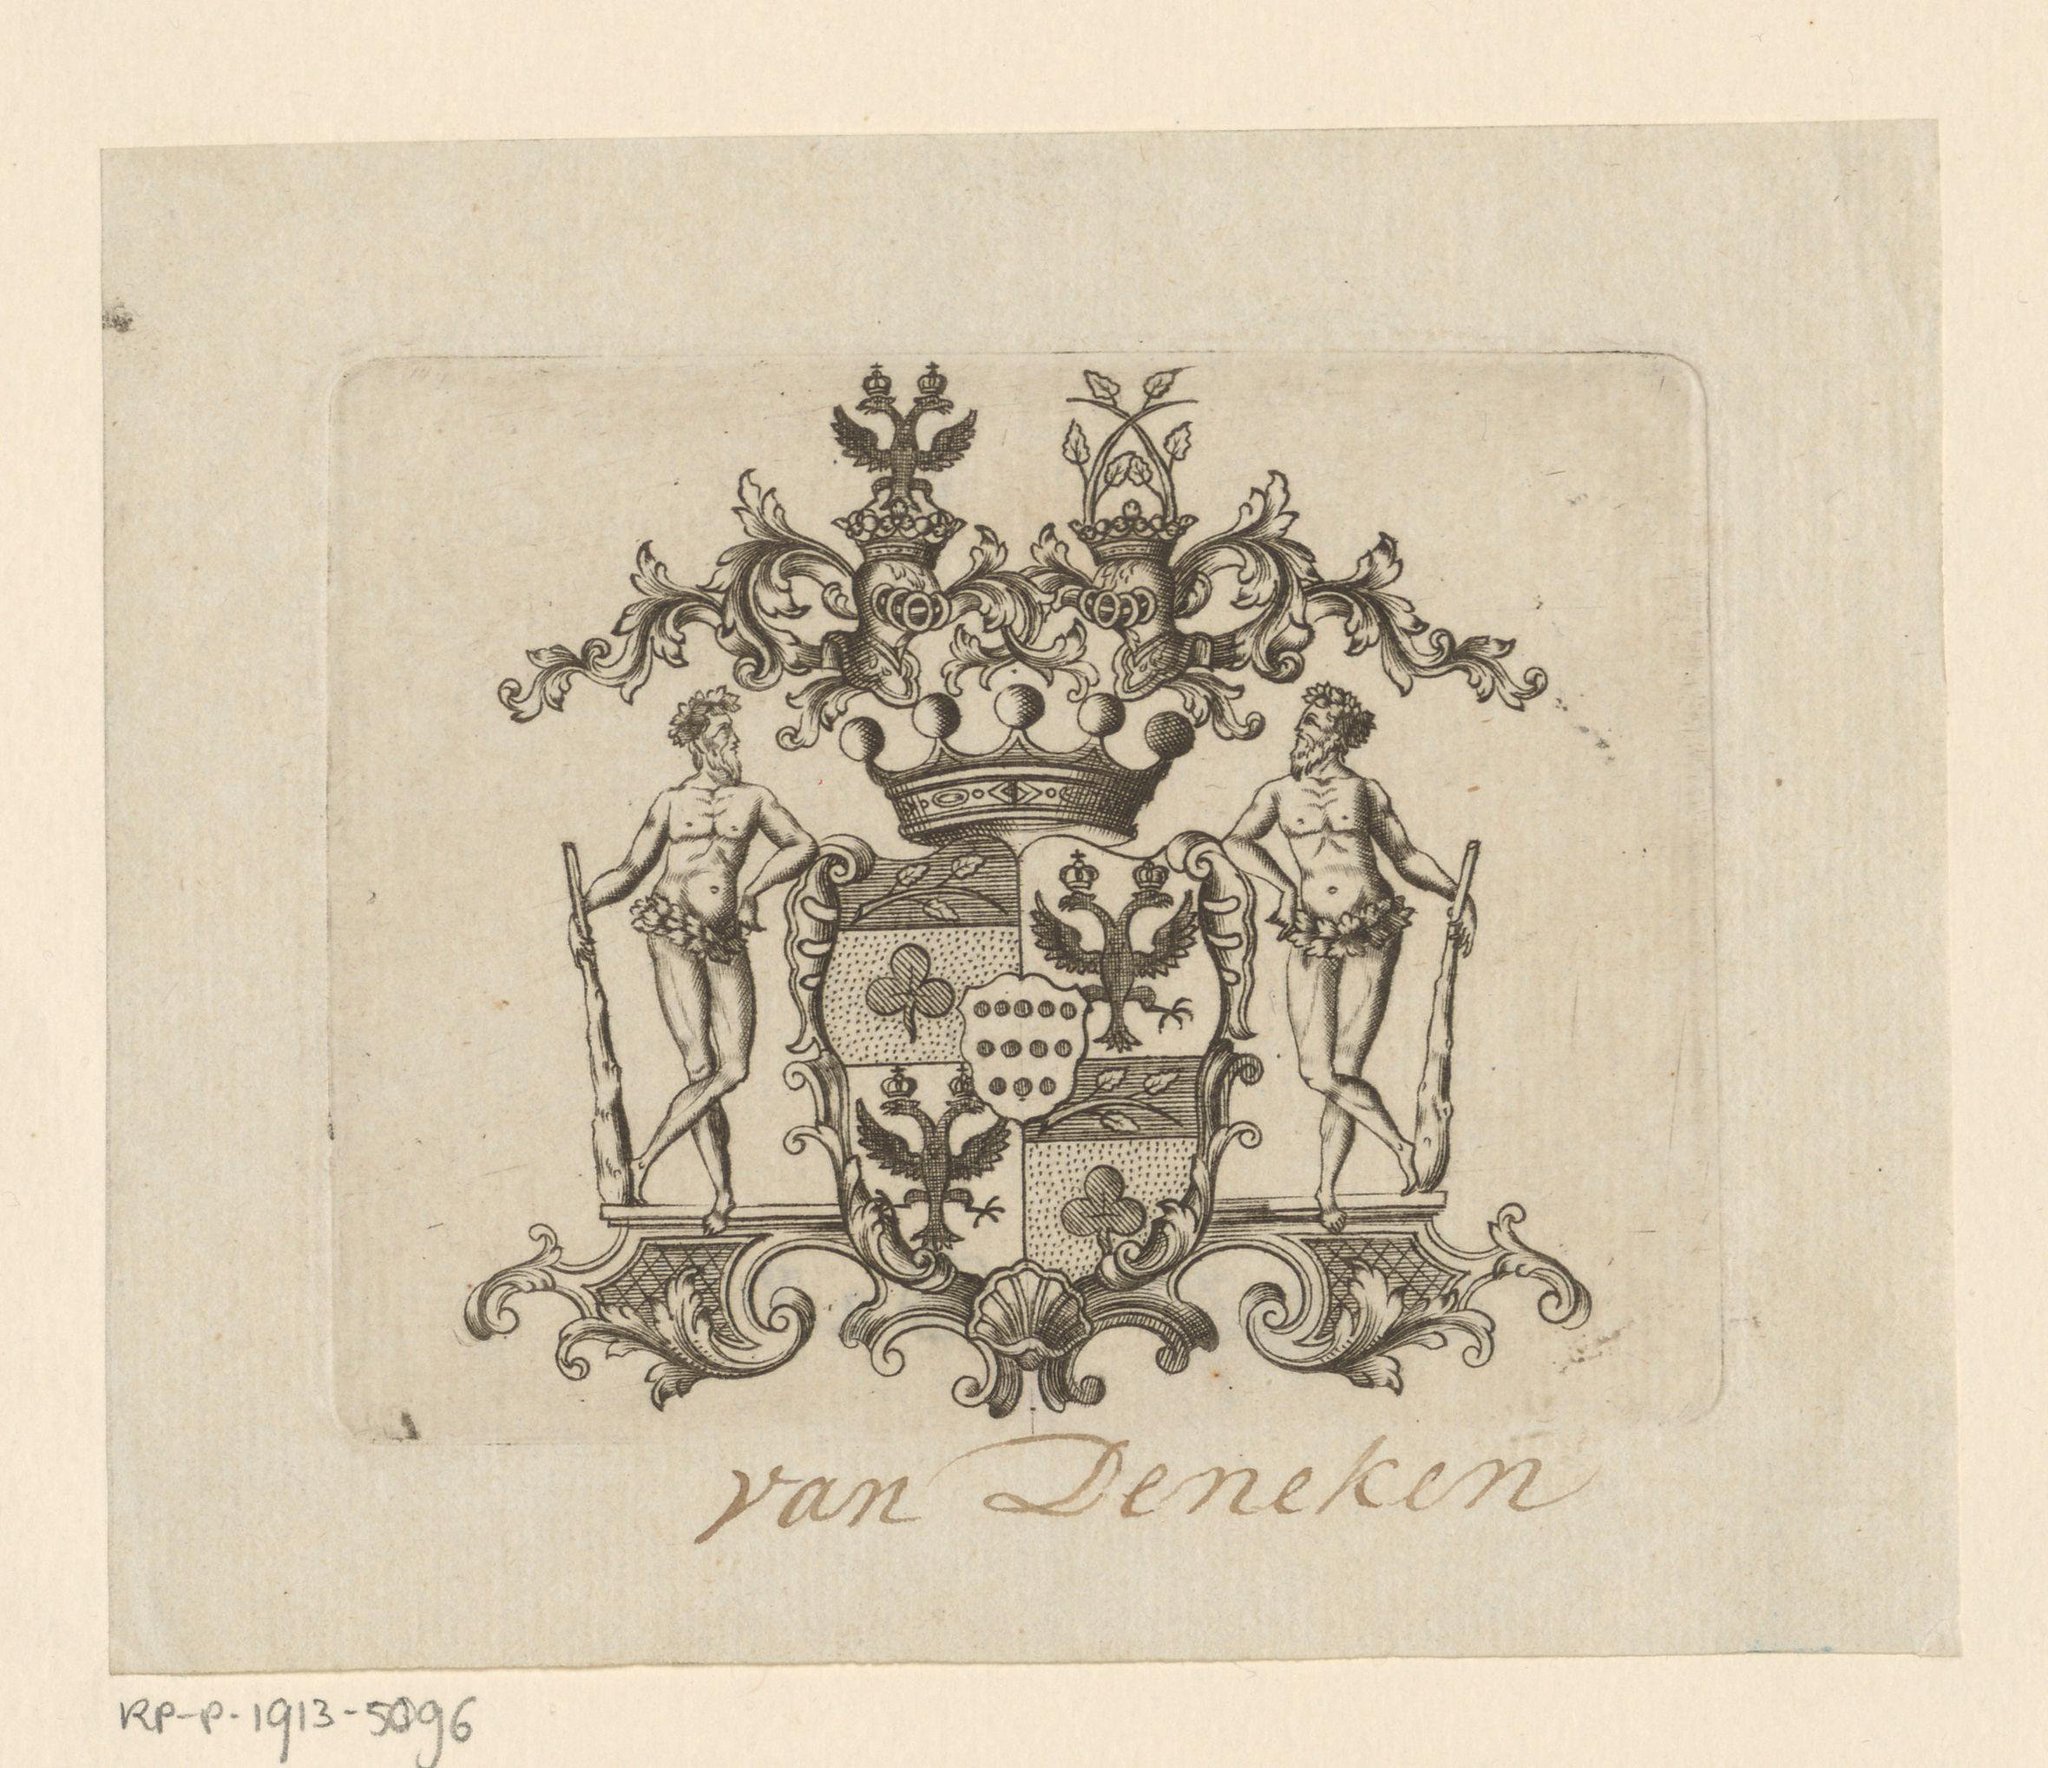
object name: bookplate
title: Ex libris van Van Deneken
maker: Anonymous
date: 1650-1749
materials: paper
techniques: etching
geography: netherlands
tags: double-headed eagle, wild man, wodewose, woodehouse, armorial bearing, heraldry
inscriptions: inscription: ‘van Deneken’, collector's mark: Lugt 2760, collector's mark: Lugt 2233